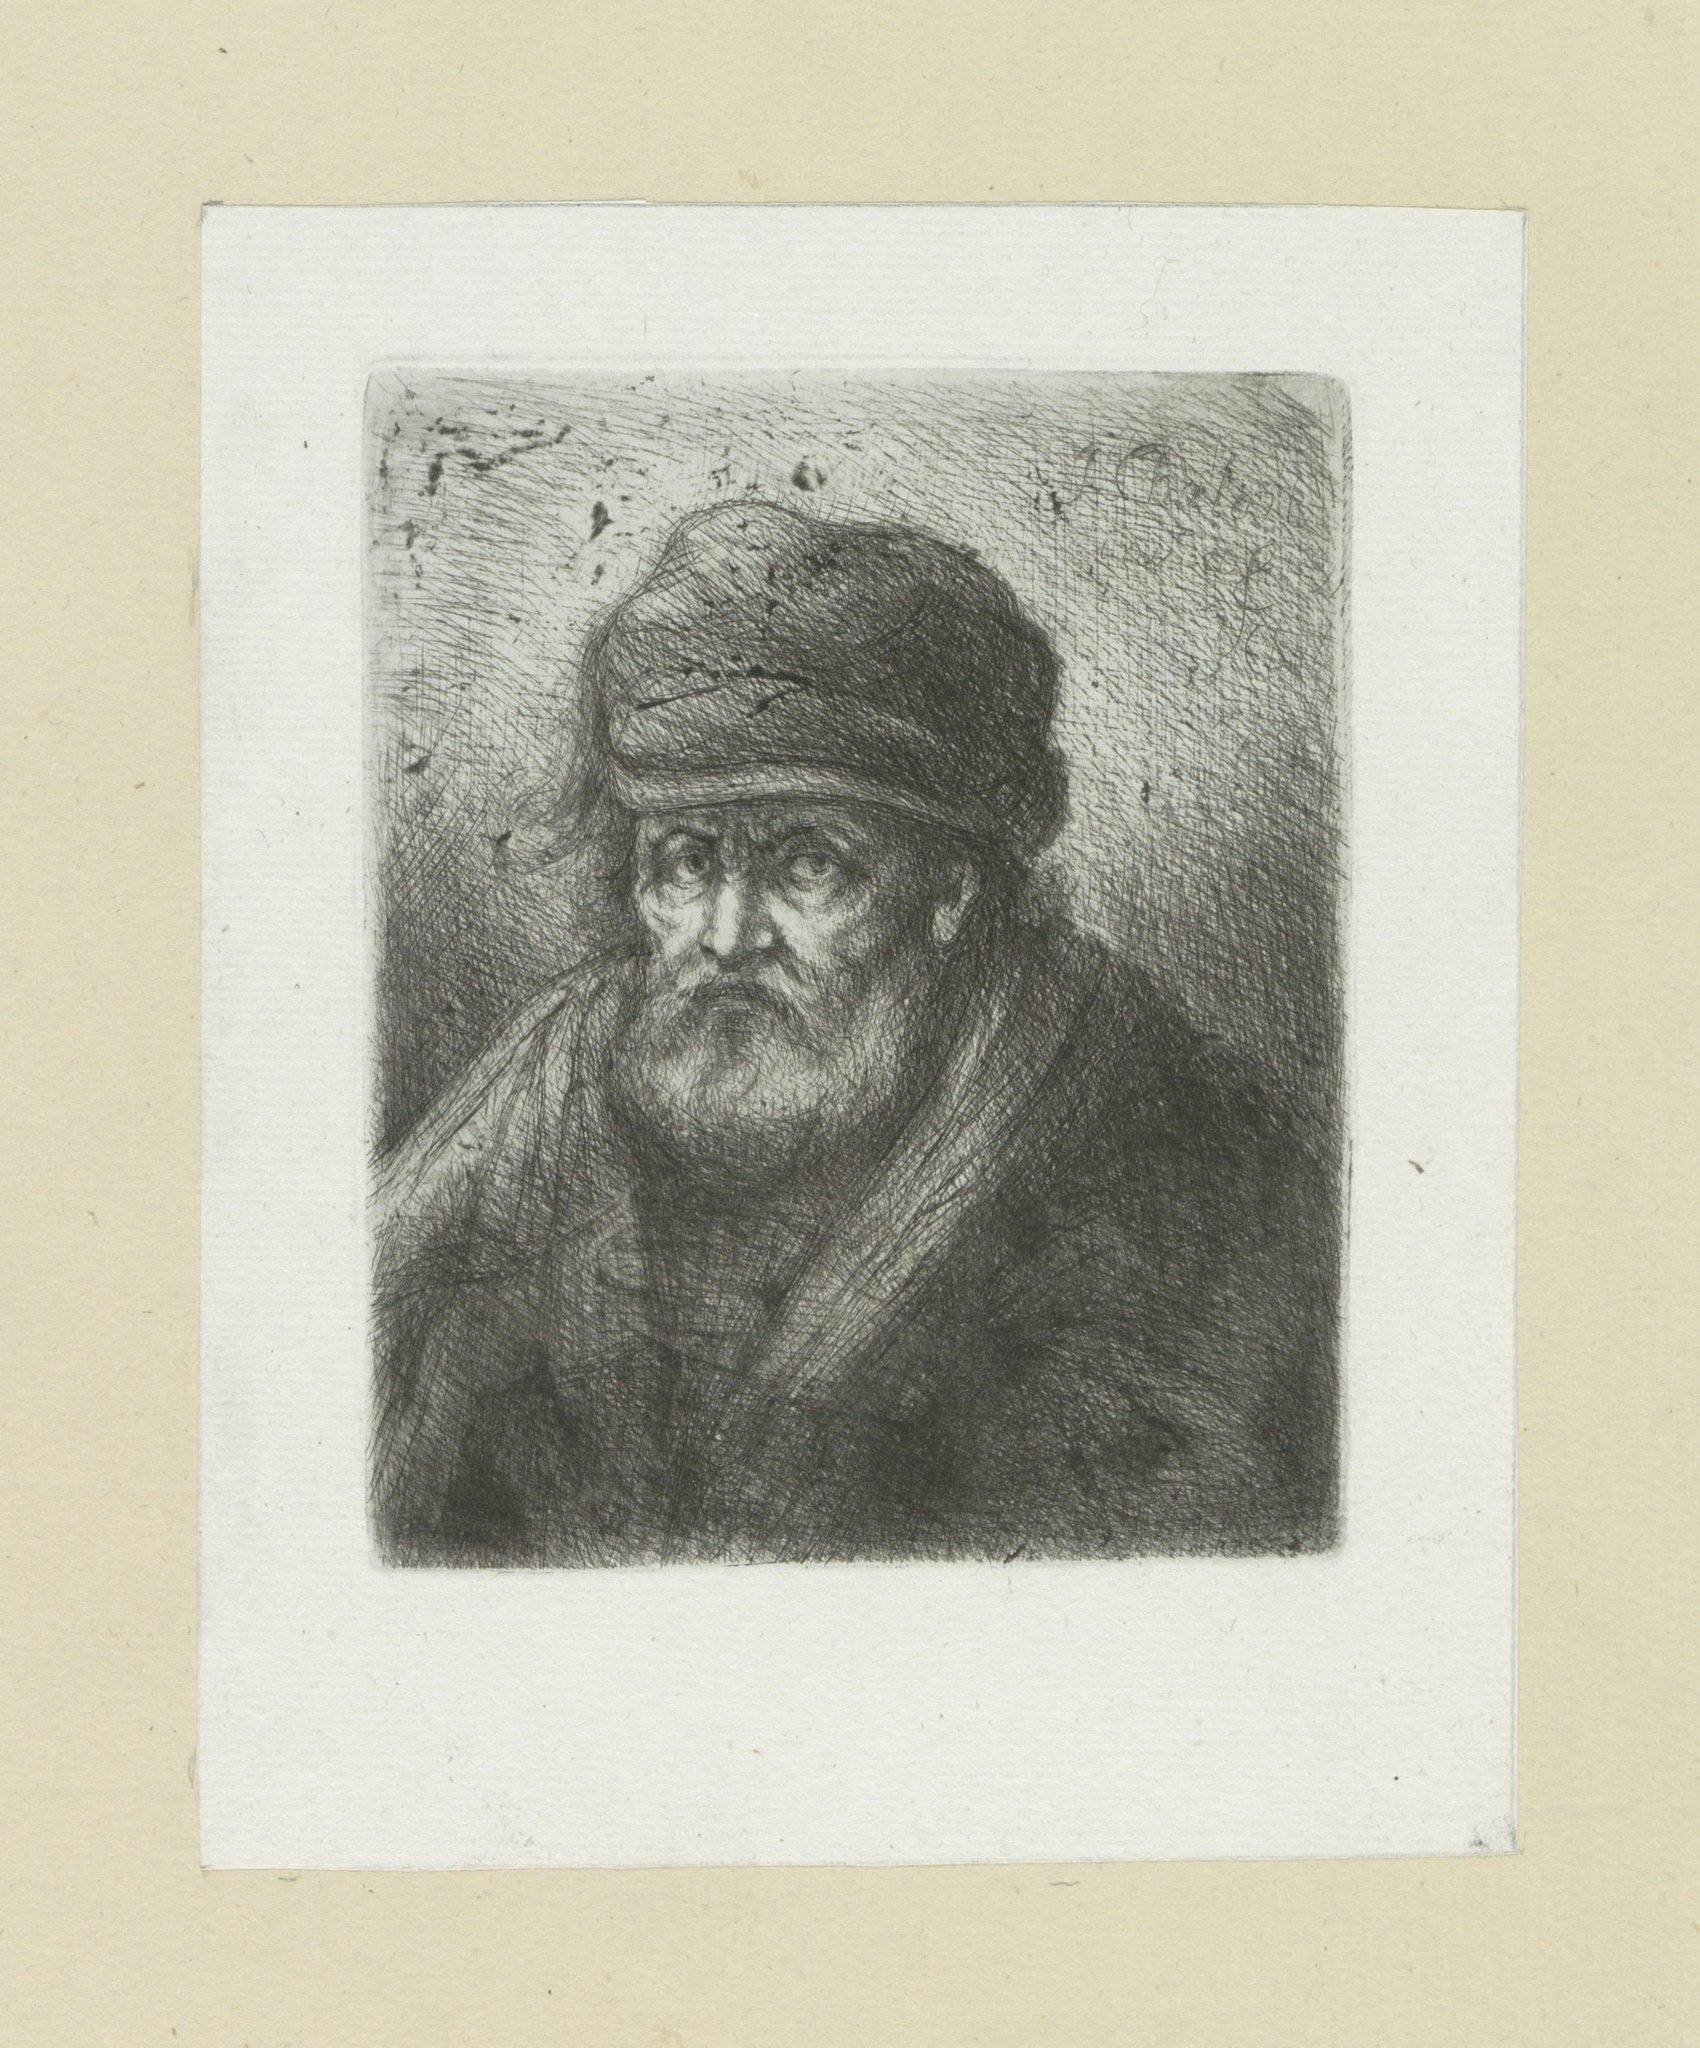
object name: album leaf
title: The Compleat Work of Etchings by John Chalon / Oeuvre Complette des Eaux Fortes par Jean Chalon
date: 1802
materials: paper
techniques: drypoint, etching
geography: london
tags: head-gear: cap (+ men's clothes), morphology of human expression (+ old male (human being))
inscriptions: collector's mark: ‘B’, collector's mark: ‘RIJKS / MUSM’